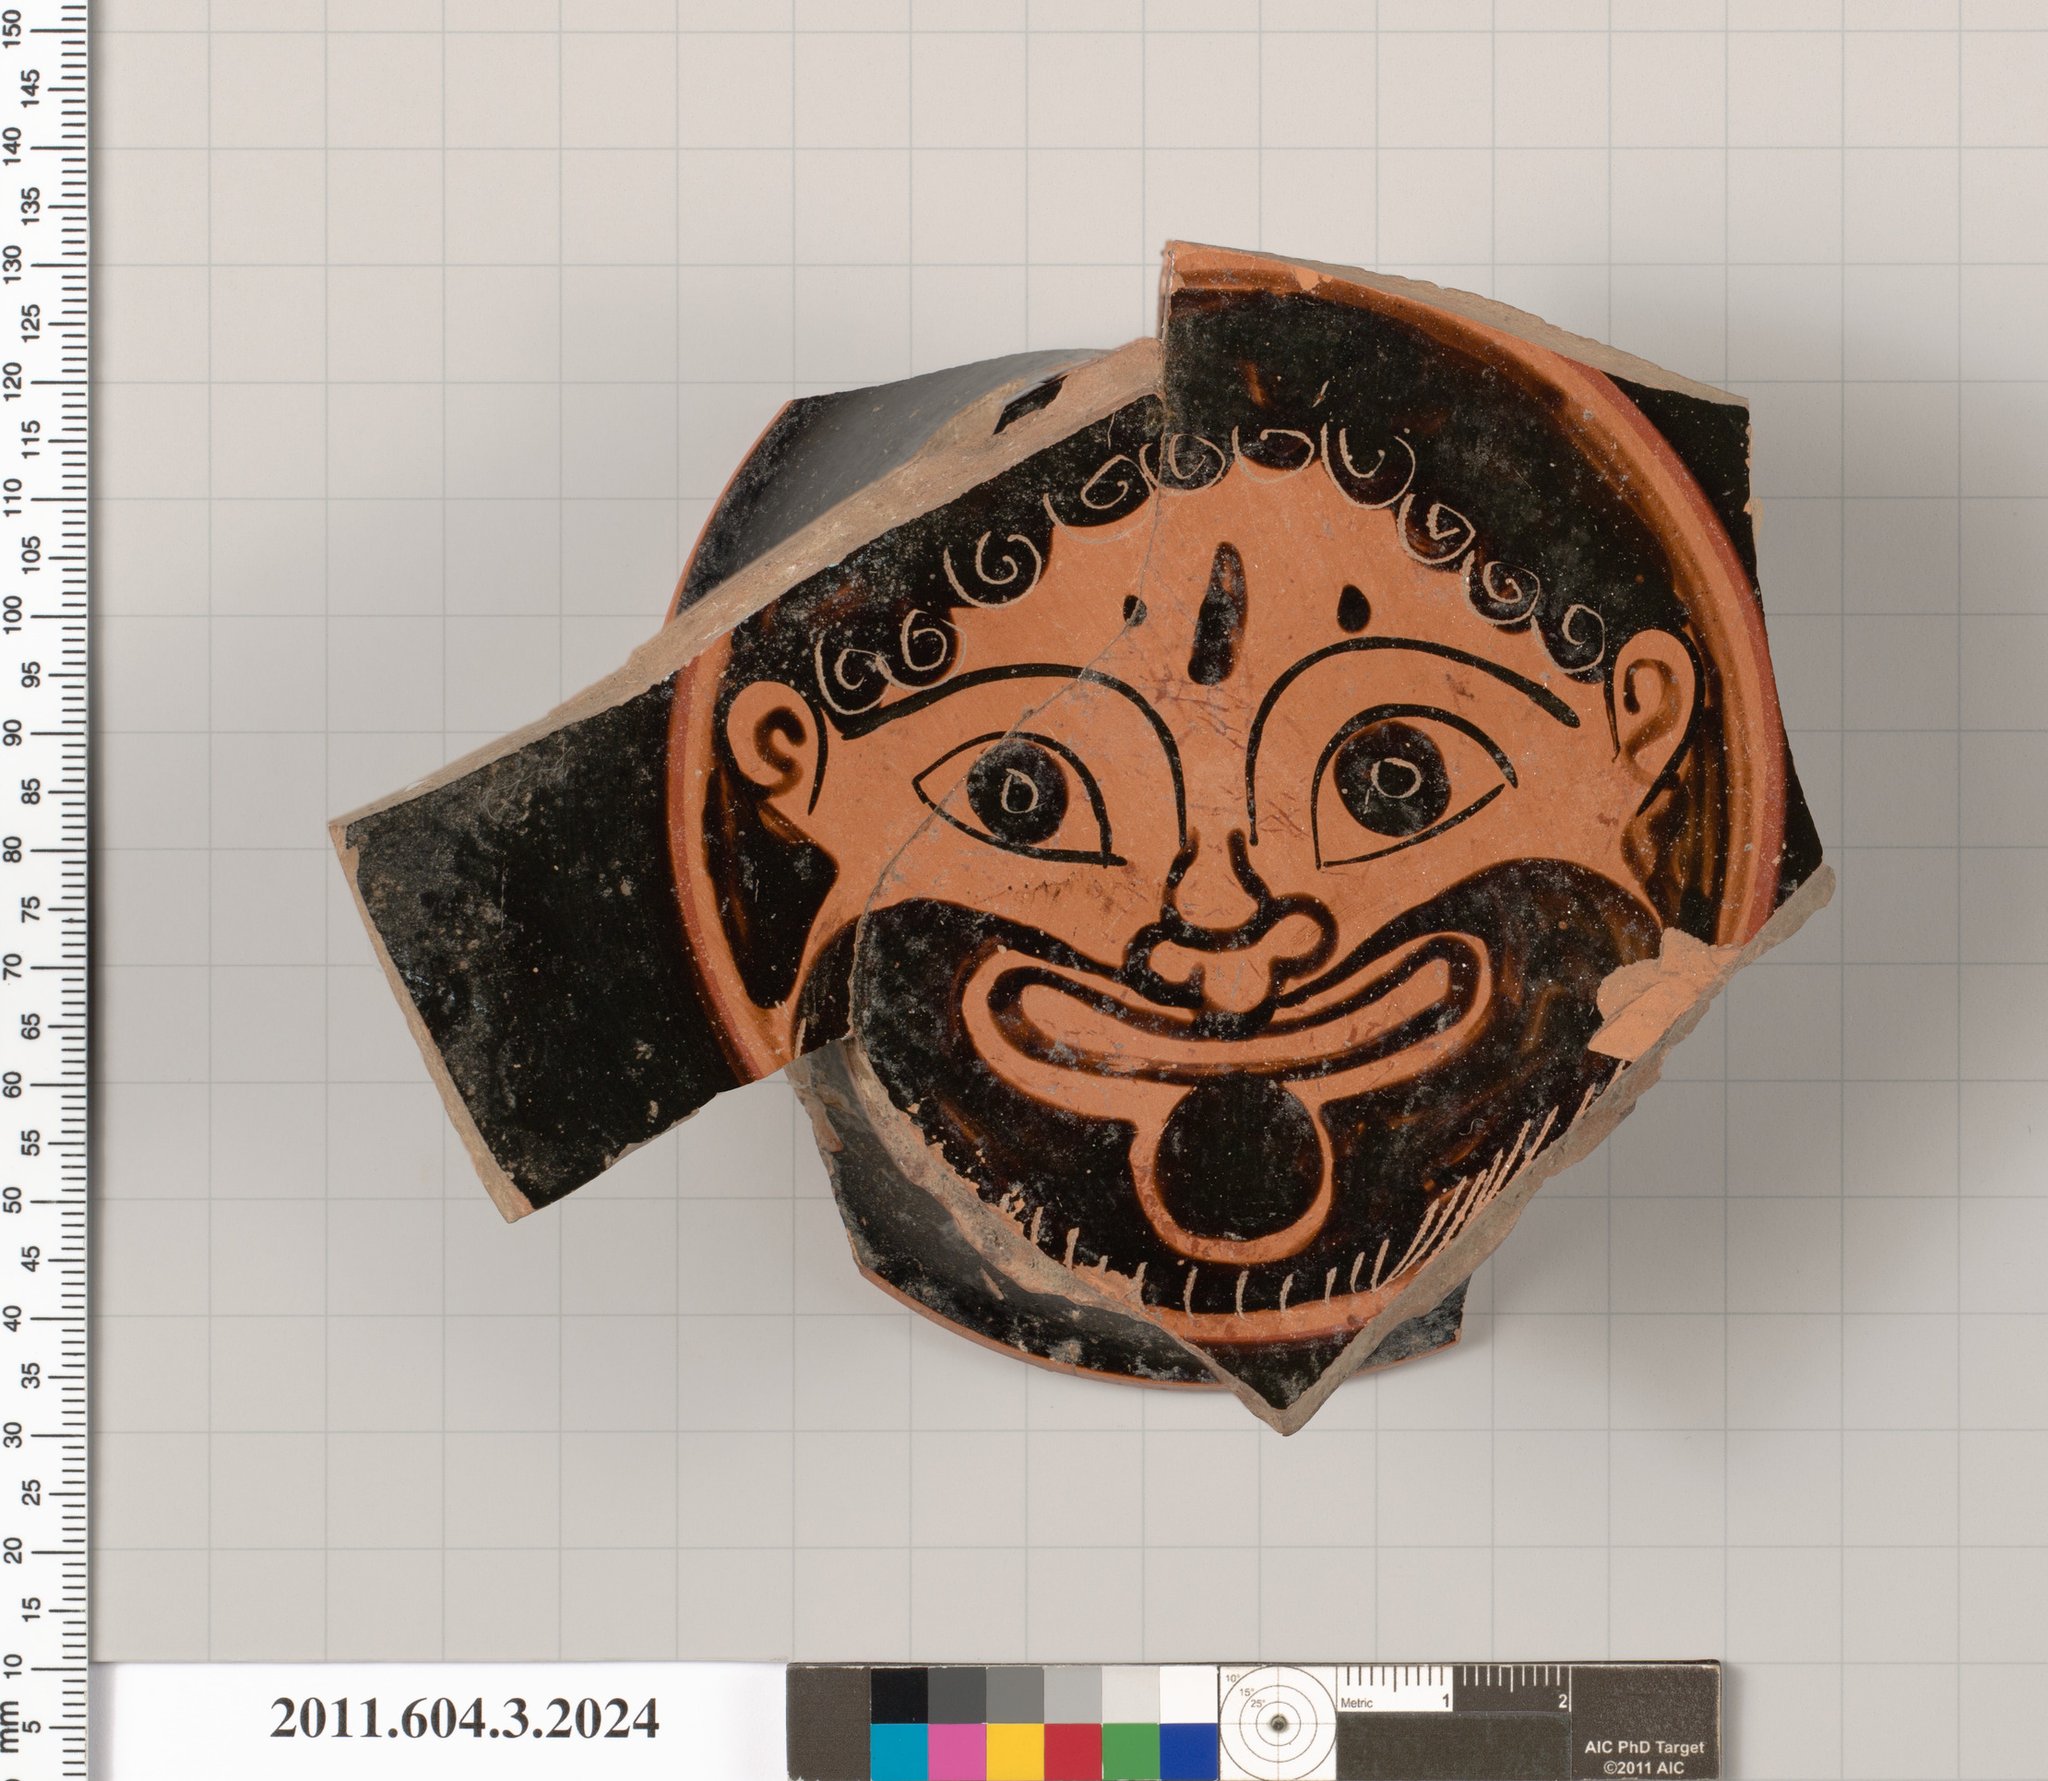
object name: kylix fragment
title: Terracotta fragment of a stemless kylix (drinking cup)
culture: greek, attic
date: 550-526 BCE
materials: terracotta